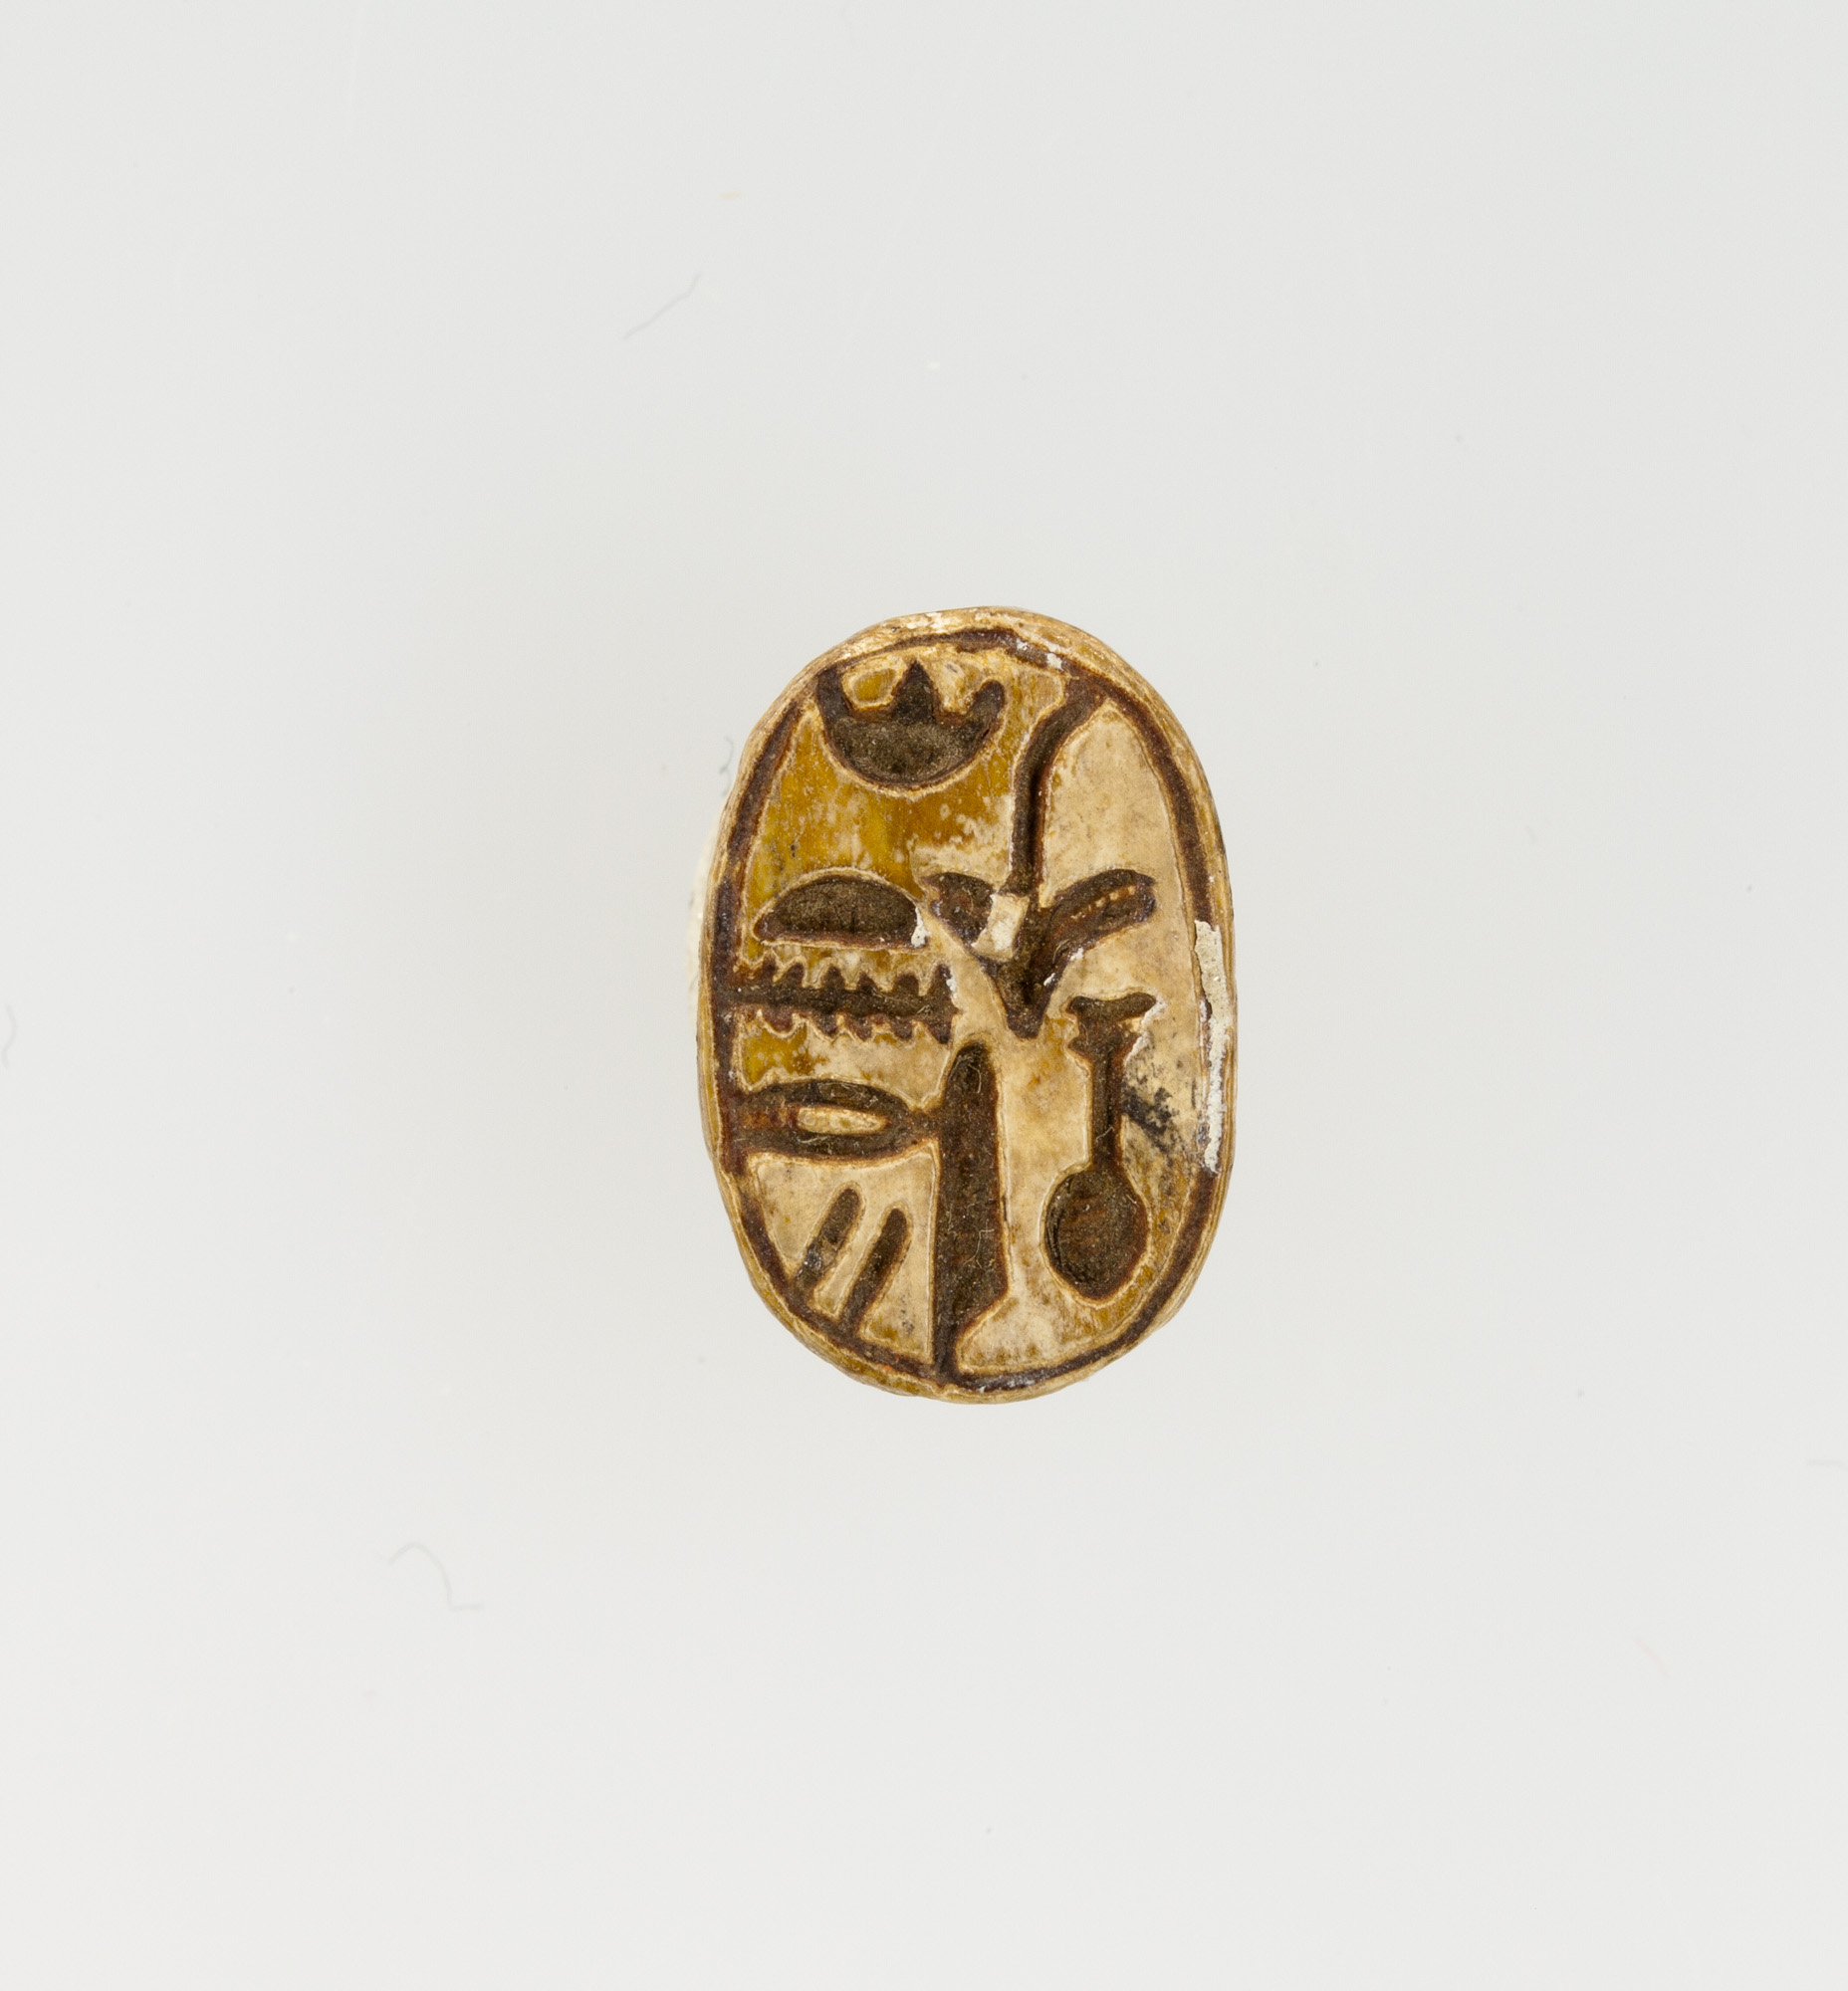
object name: scarab, ahmose nefertari, king's wife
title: Scarab Inscribed for Queen (Ahmose-)Nefertari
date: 1550-1525 BCE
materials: stone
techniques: glazing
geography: egypt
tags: hieroglyphs,scarabs